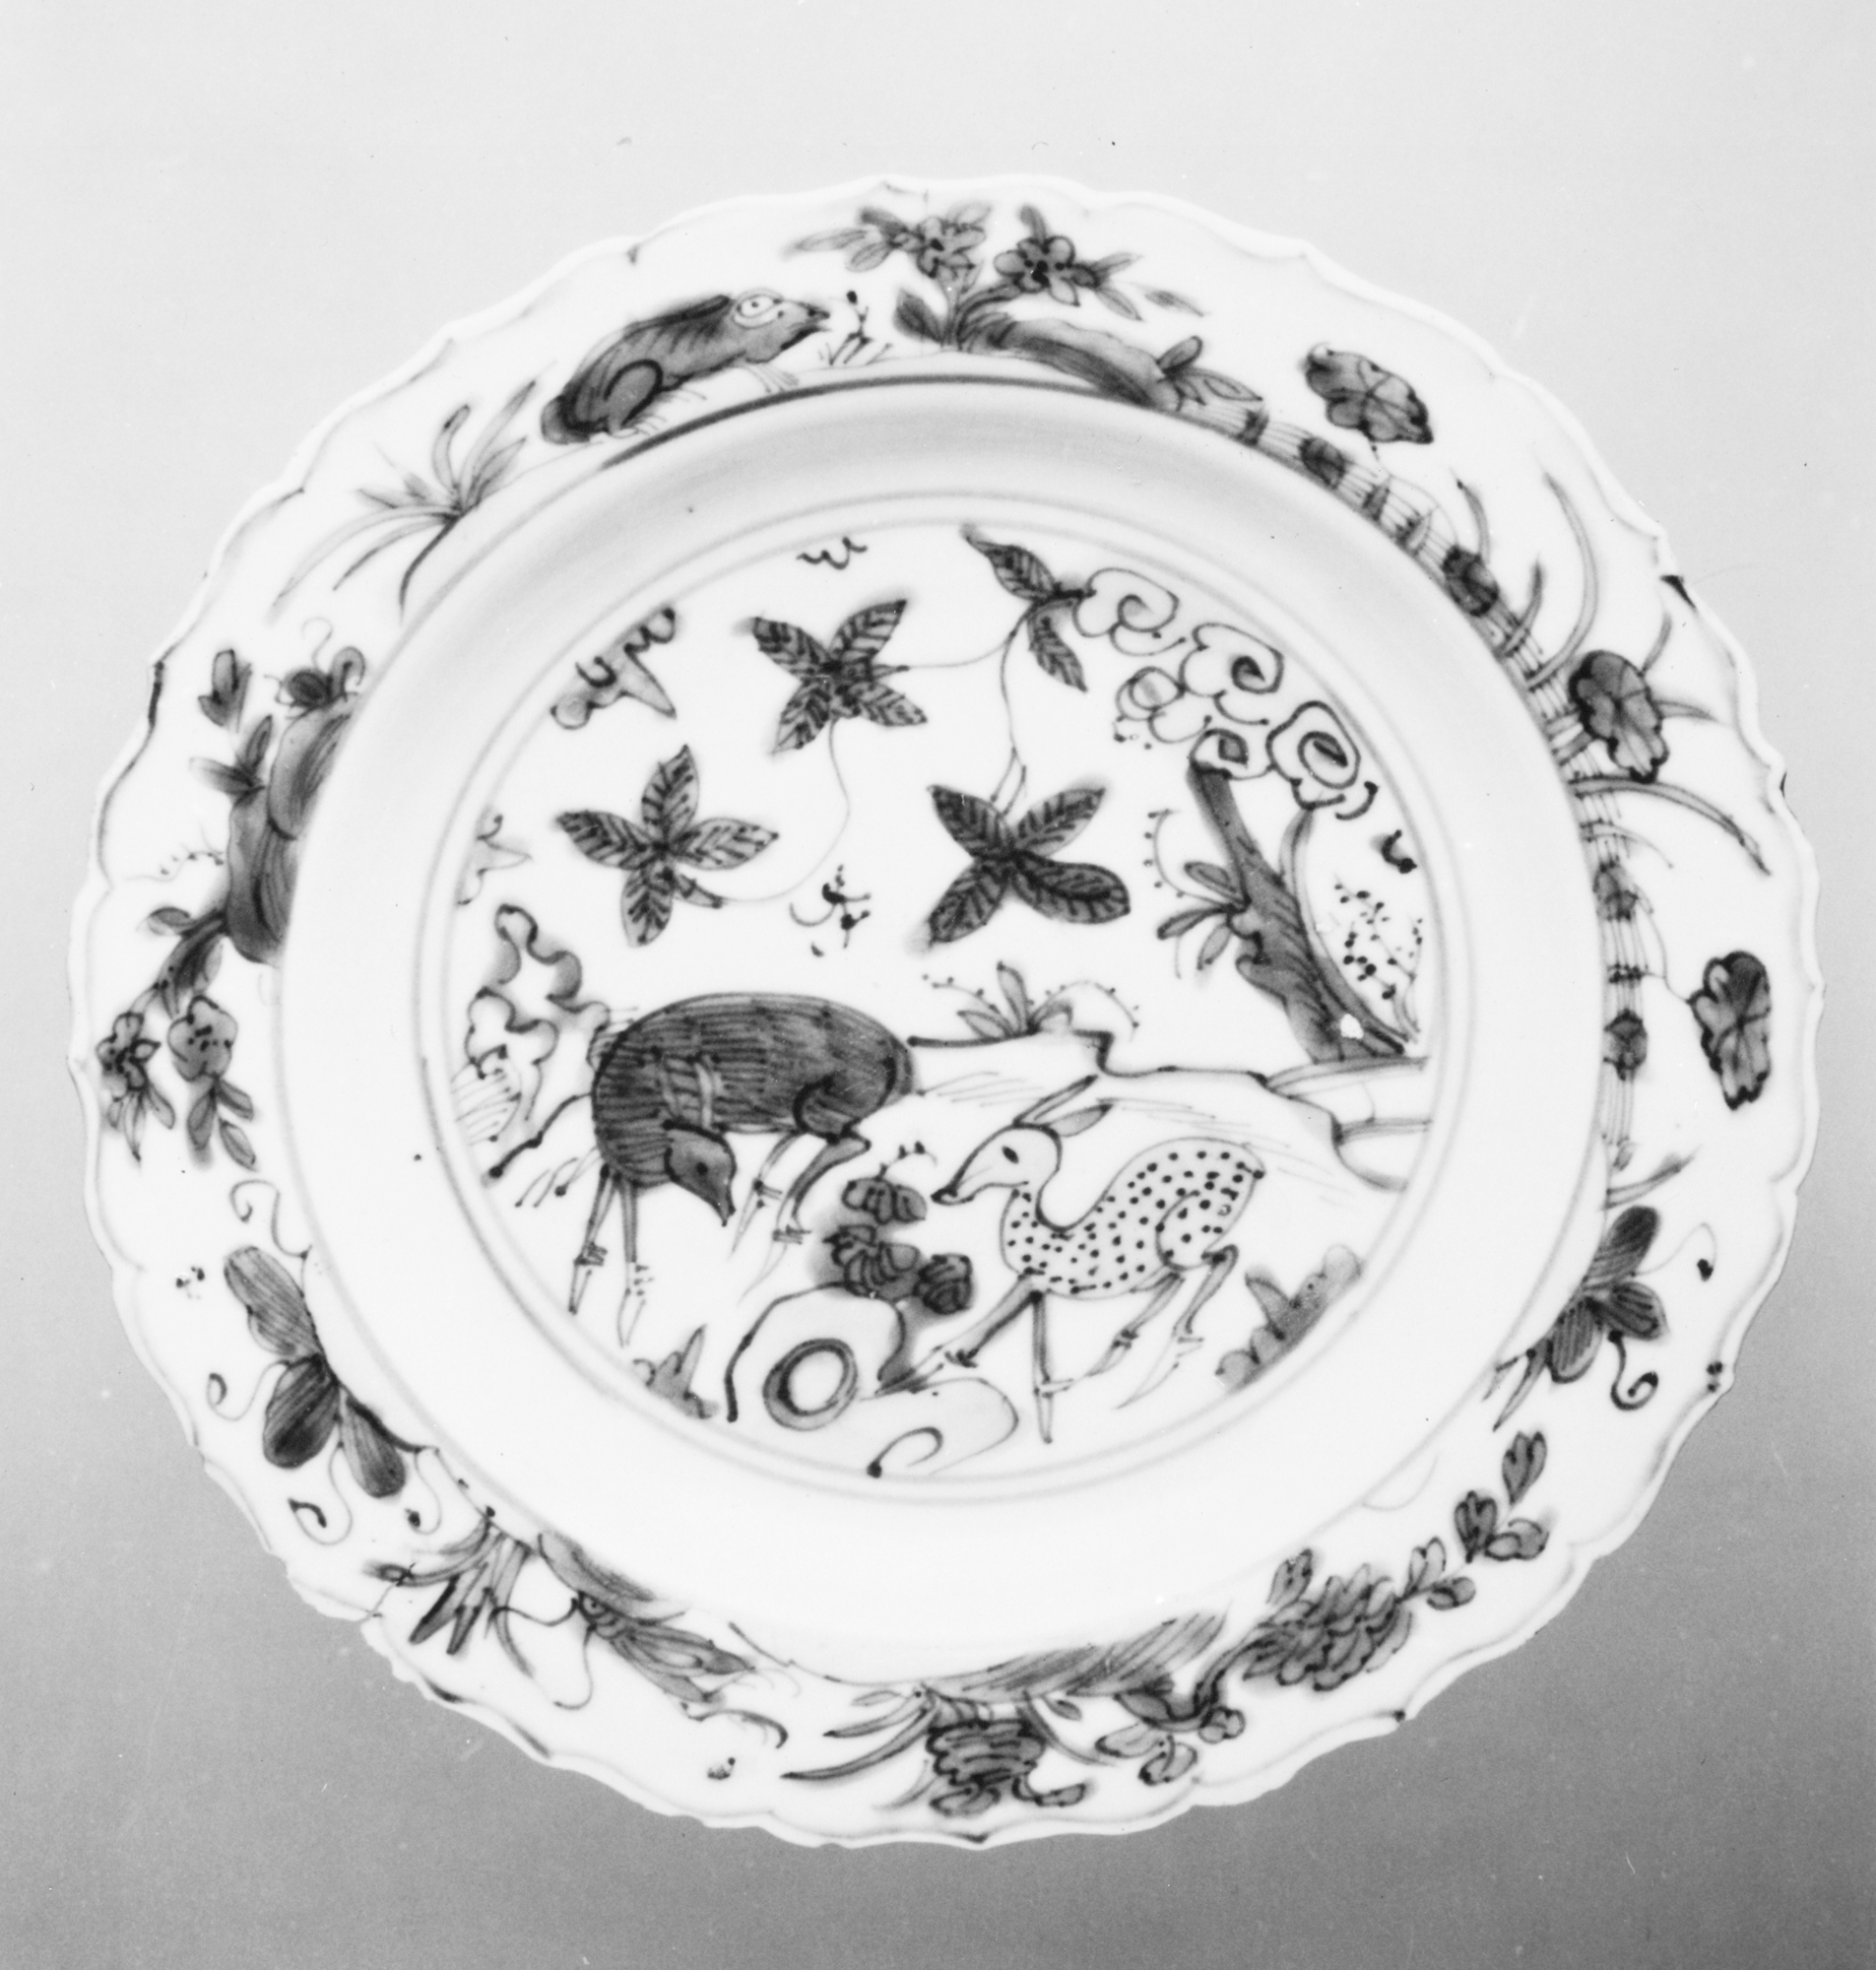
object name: plate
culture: chinese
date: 1368-1644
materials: porcelain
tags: deer,leaves